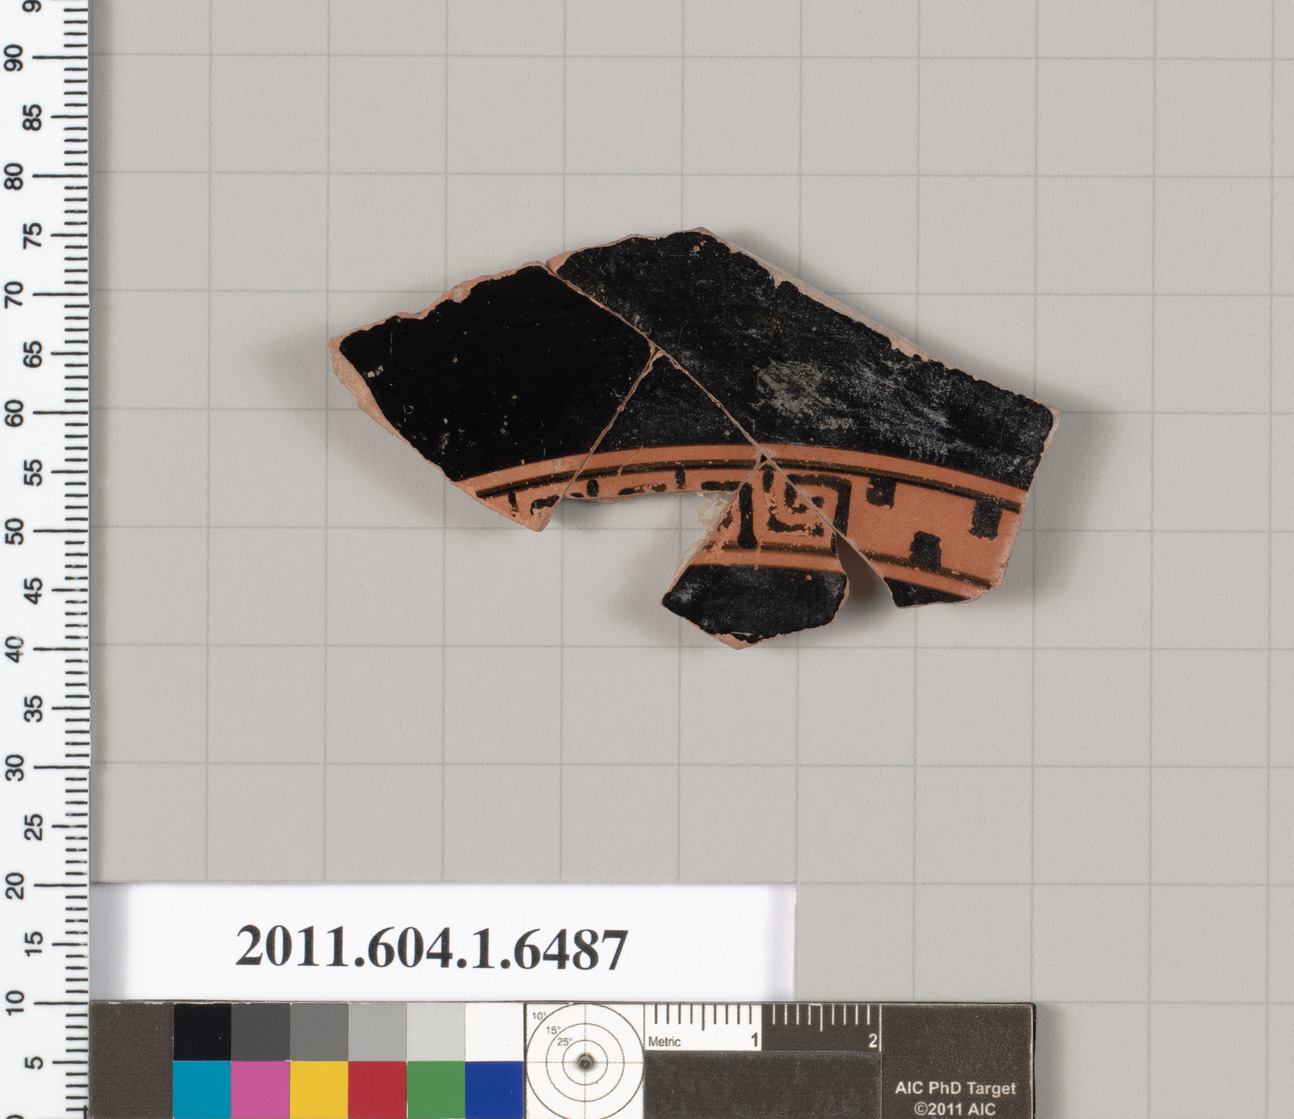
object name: kylix fragment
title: Terracotta fragment of a kylix (drinking cup)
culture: greek, attic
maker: antiphon painter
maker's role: artist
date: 490-480 BCE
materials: terracotta